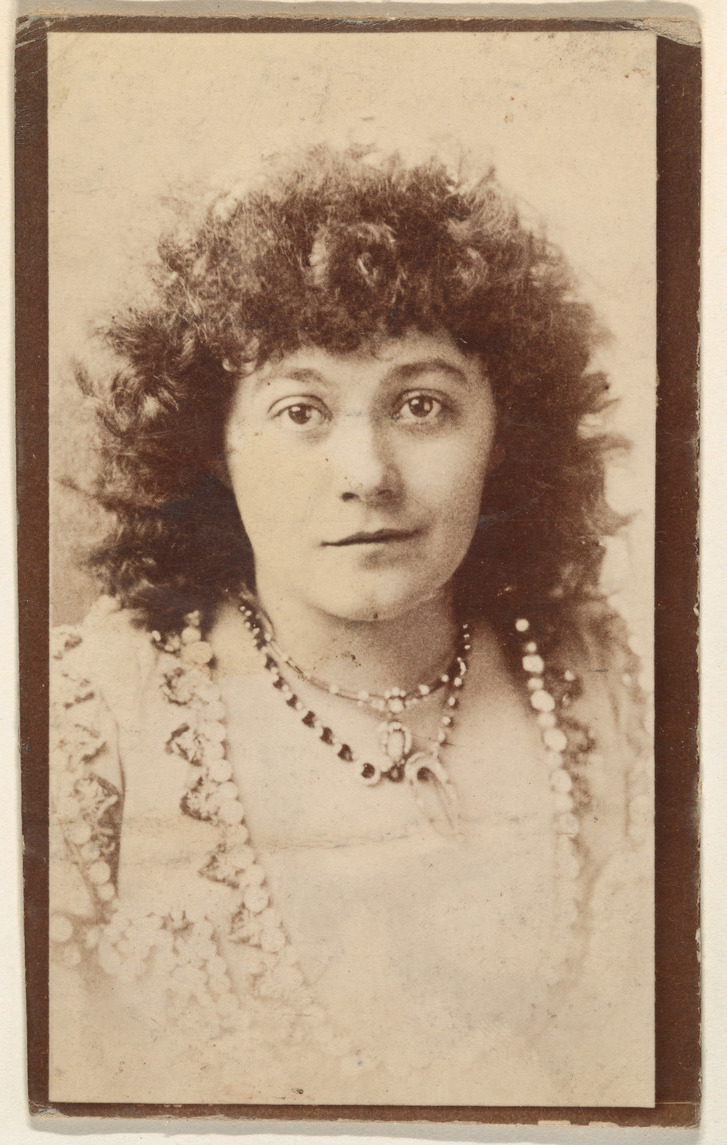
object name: photograph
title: Portrait of actress wearing multiple necklaces, from the Actresses series (N668)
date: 1888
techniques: albumen silver print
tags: portraits,women,actresses